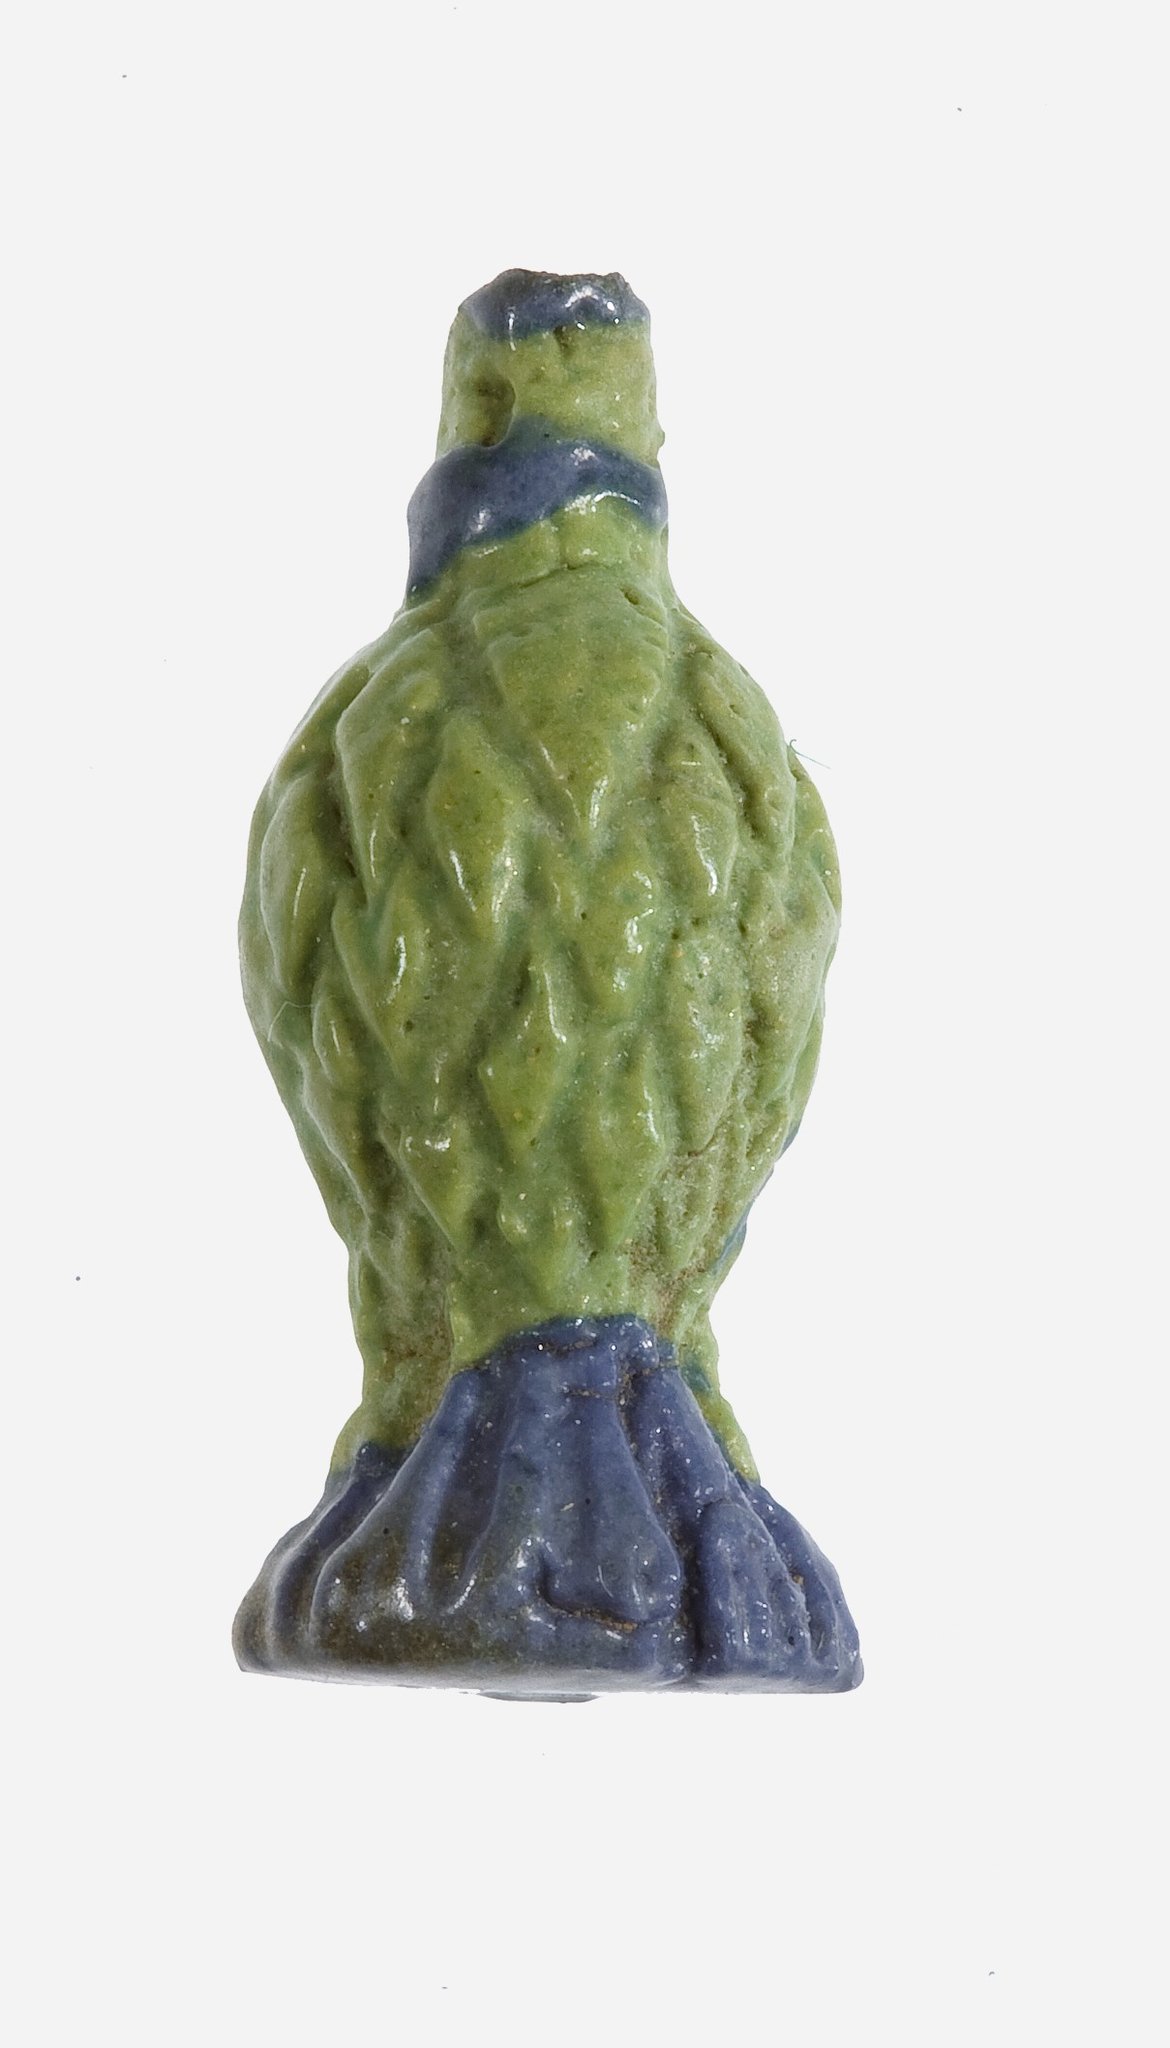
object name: bead, cornflower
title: Bead in the Form of a Cornflower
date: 1390-1352 BCE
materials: faience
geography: egypt